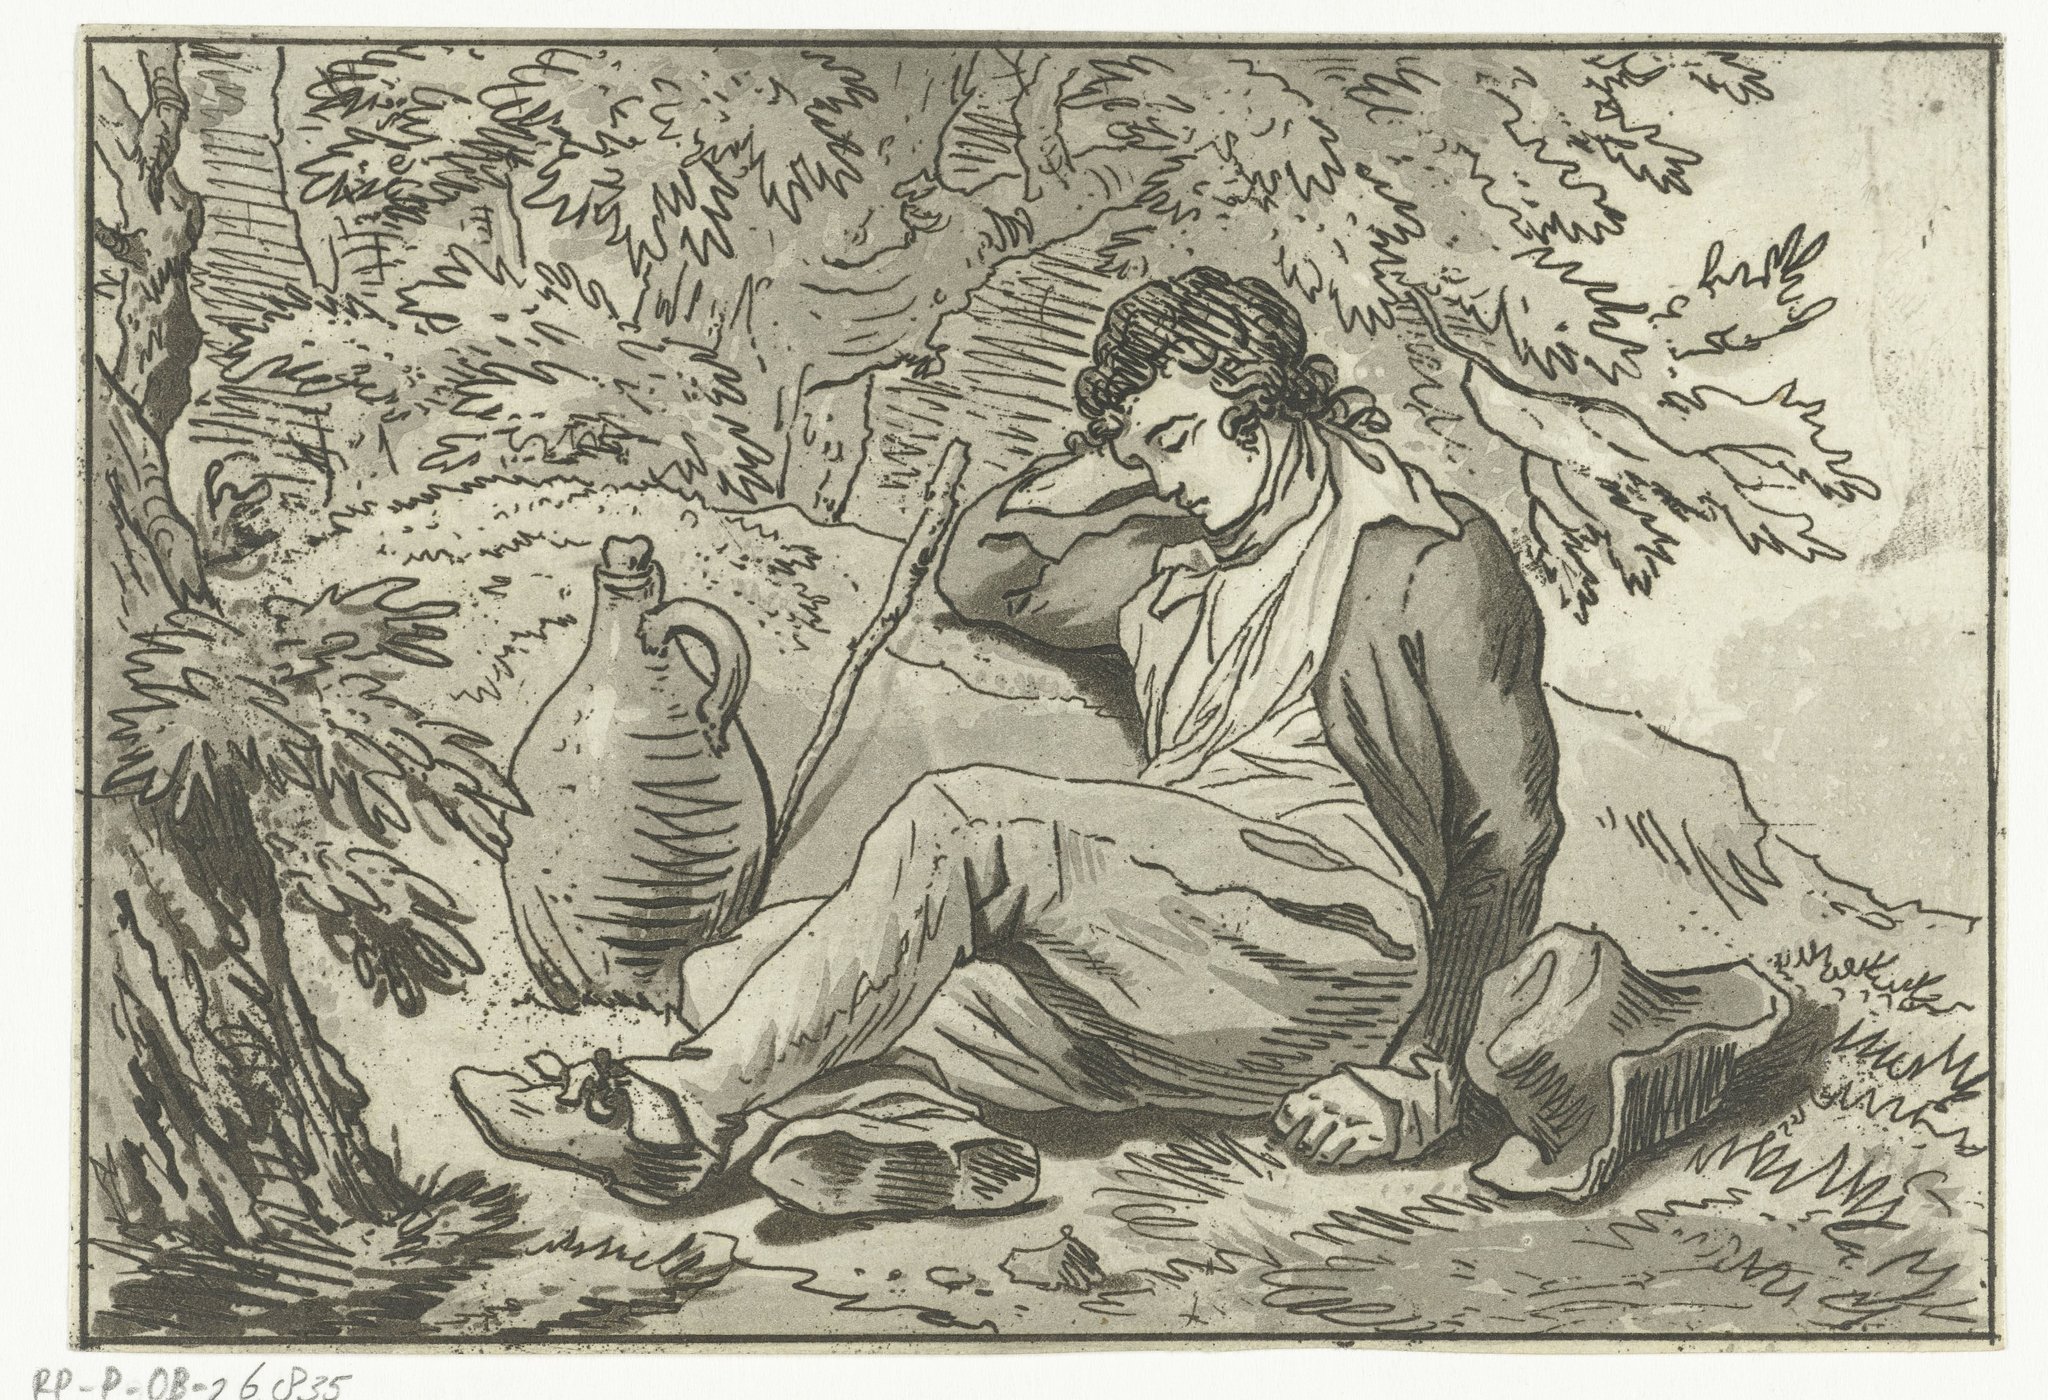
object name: print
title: Zittende slapende jongen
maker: anthonie van den bos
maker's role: draughtsman, print maker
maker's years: 1763-1838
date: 1778-1838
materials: paper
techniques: aquatint, etching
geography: netherlands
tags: sleeping; unconsciousness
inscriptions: collector's mark: Lugt 2228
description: Slapende herder, zittend naast een kruik met wijn. Zijn hoed ligt naast hem in het gras.